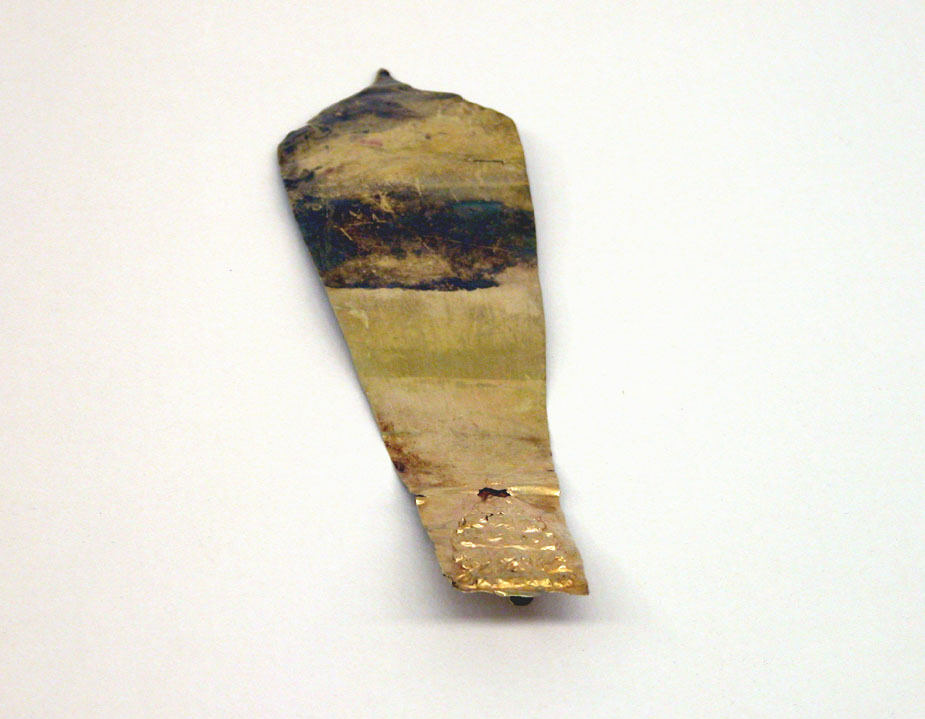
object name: petal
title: Four Petals from a Lotus Base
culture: indonesian, javanese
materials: gold